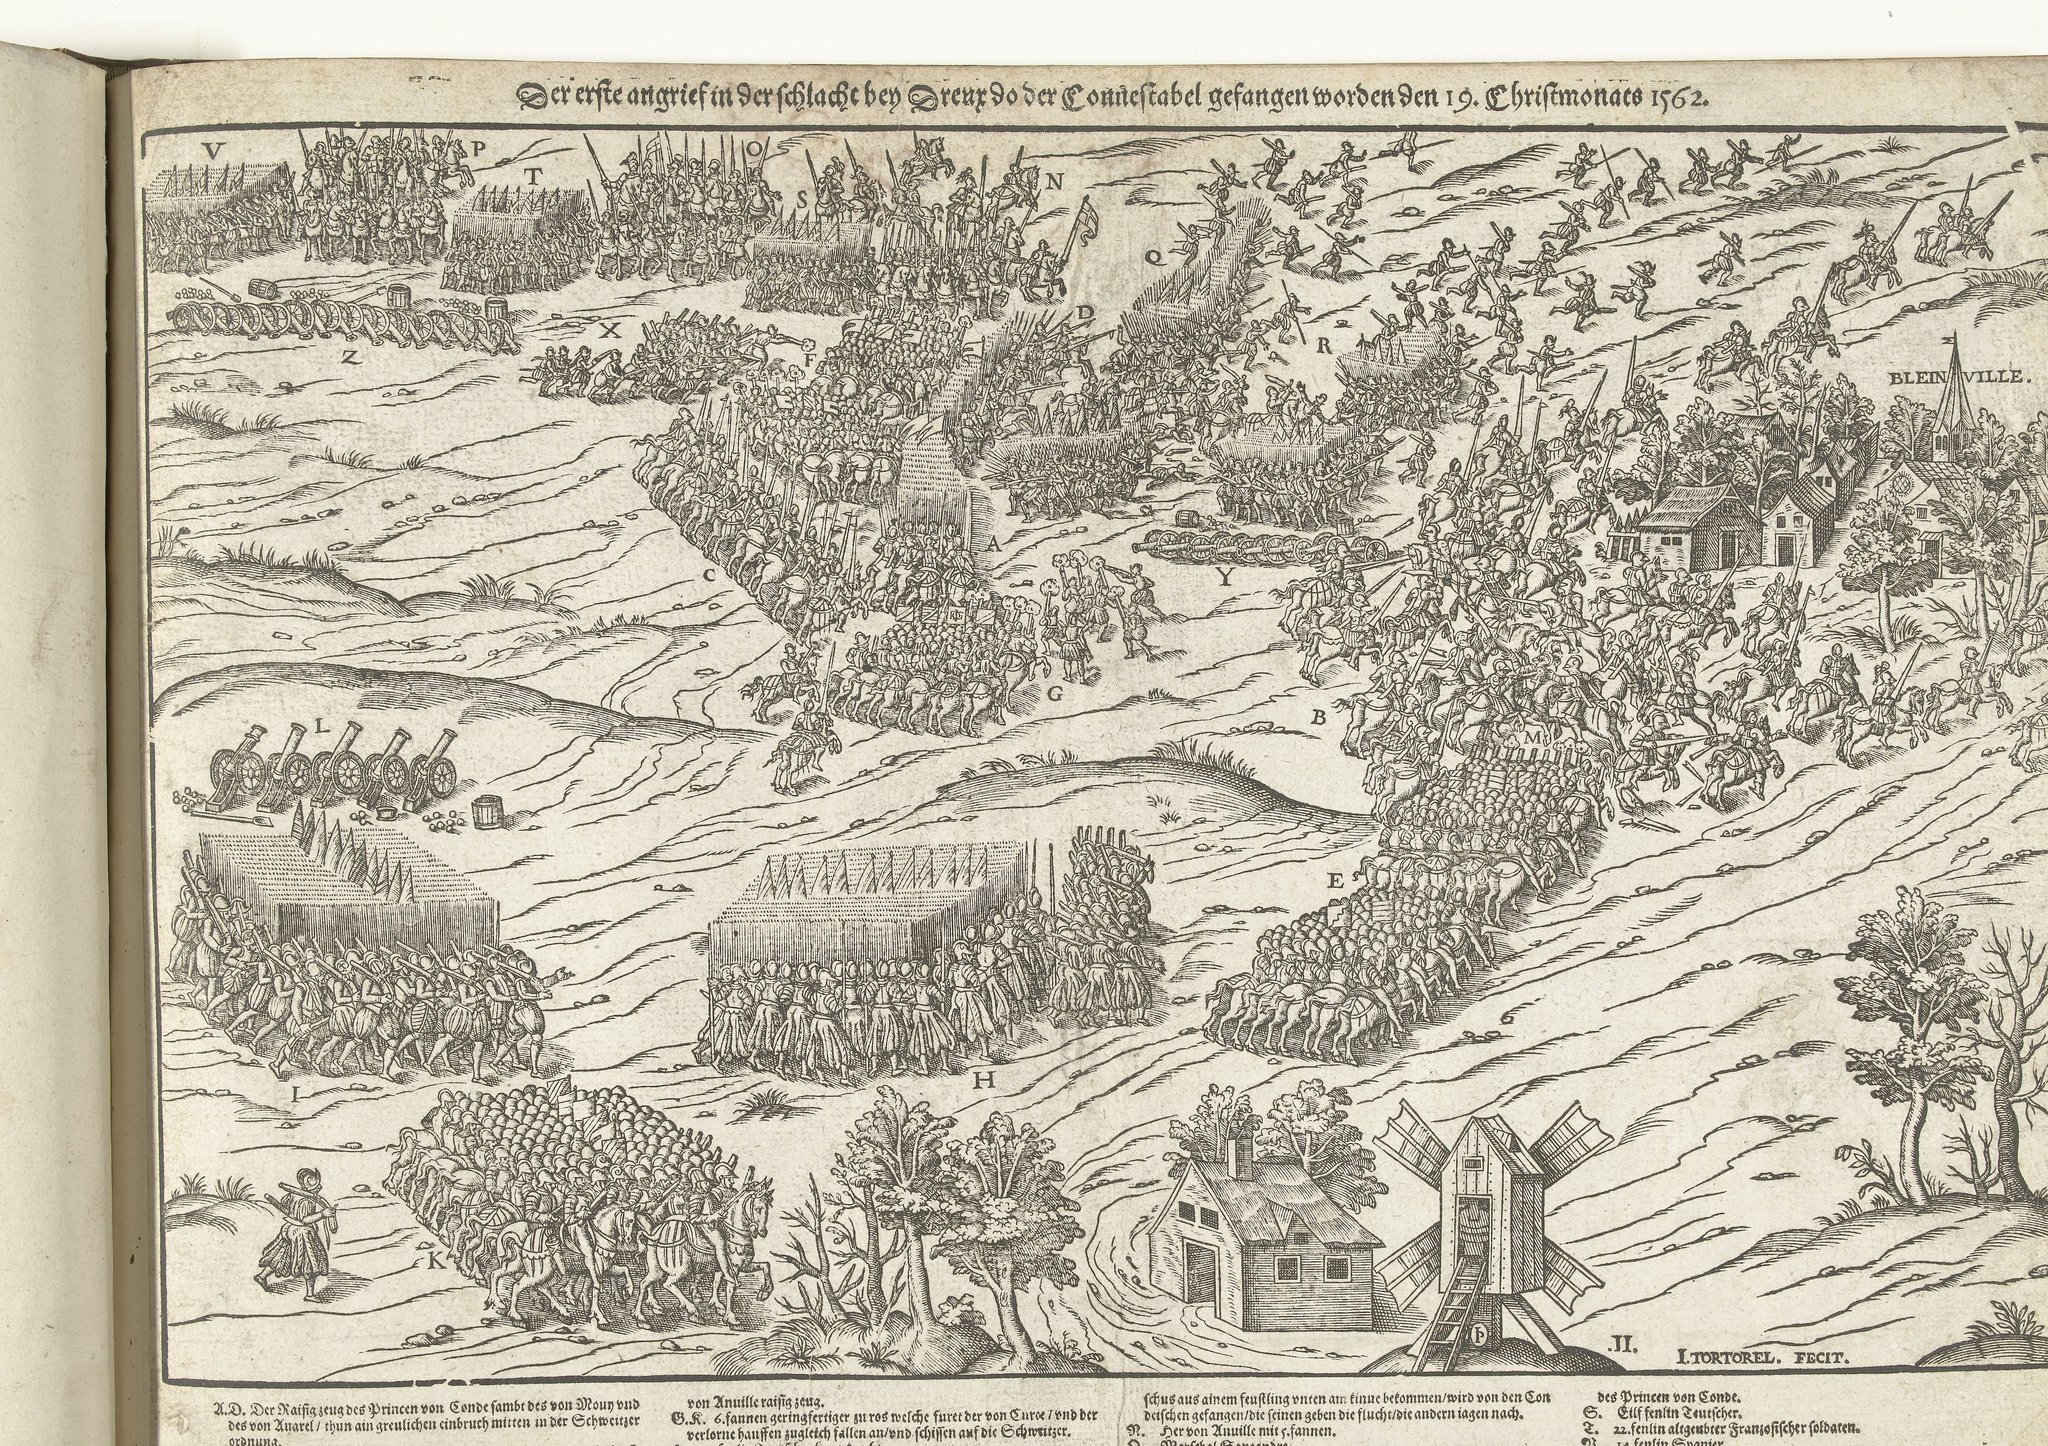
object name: history print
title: Slag bij Dreux, eerste treffen, 1562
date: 1570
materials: paper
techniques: letterpress printing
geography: france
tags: battle, fighting in general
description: Slag bij Dreux tussen de hugenoten en de katholieken, eerste treffen, 19 december 1562. Gezicht op het slagveld. In het onderschrift de legenda A-Z in het Duits. Ongenummerd.